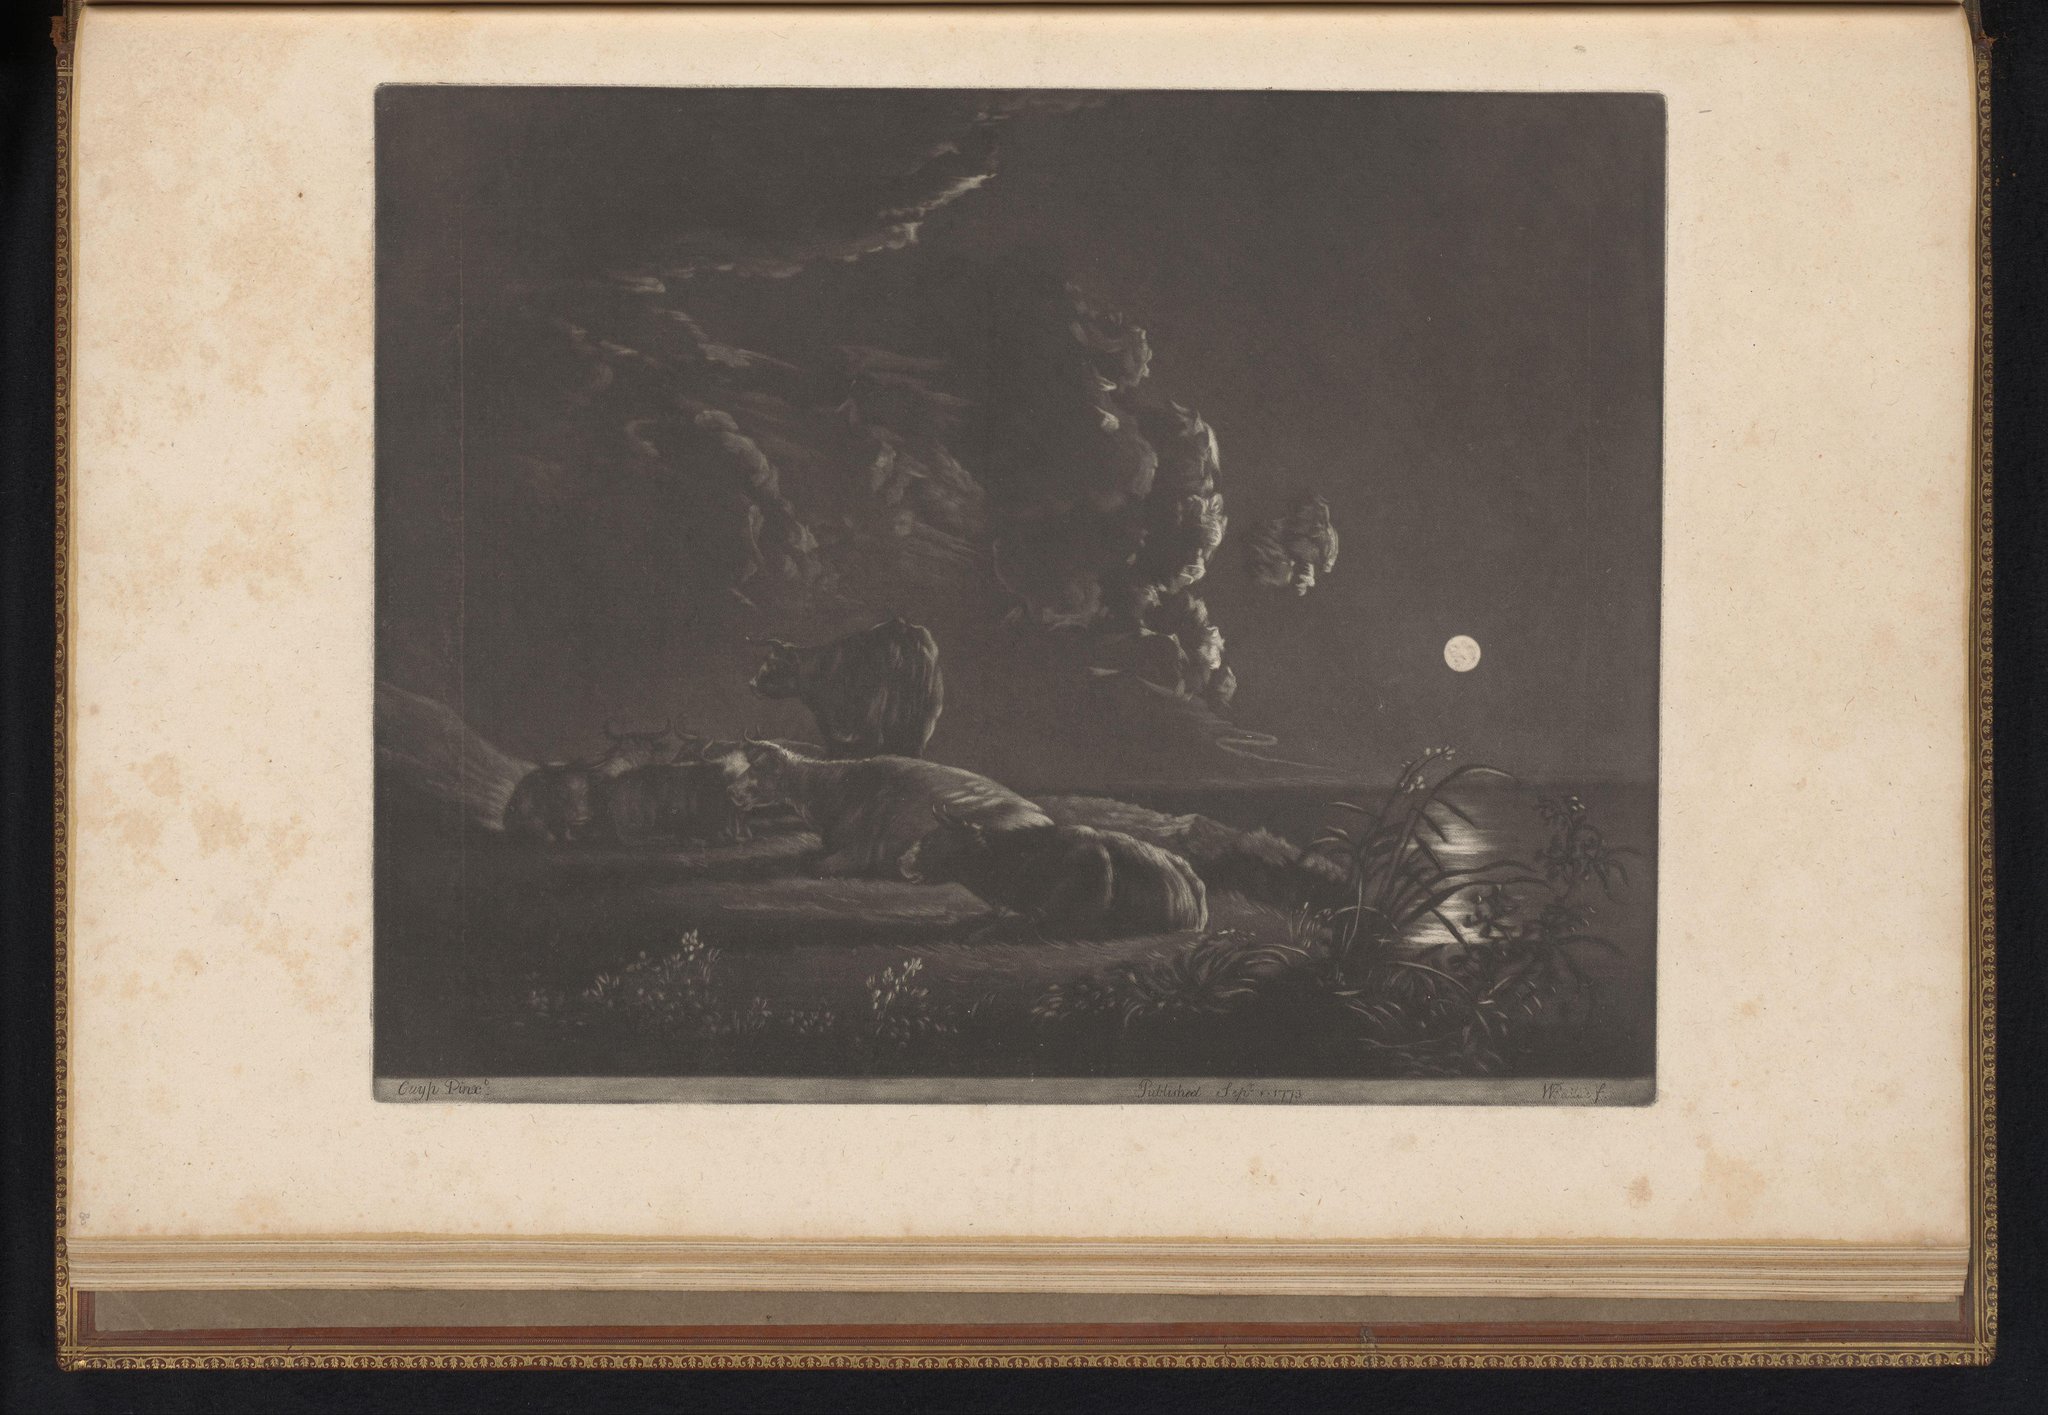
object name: album leaf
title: Landschap met een kudde bij maanlicht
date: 1773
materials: paper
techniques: etching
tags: landscapes, moonlight, herd, flock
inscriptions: date